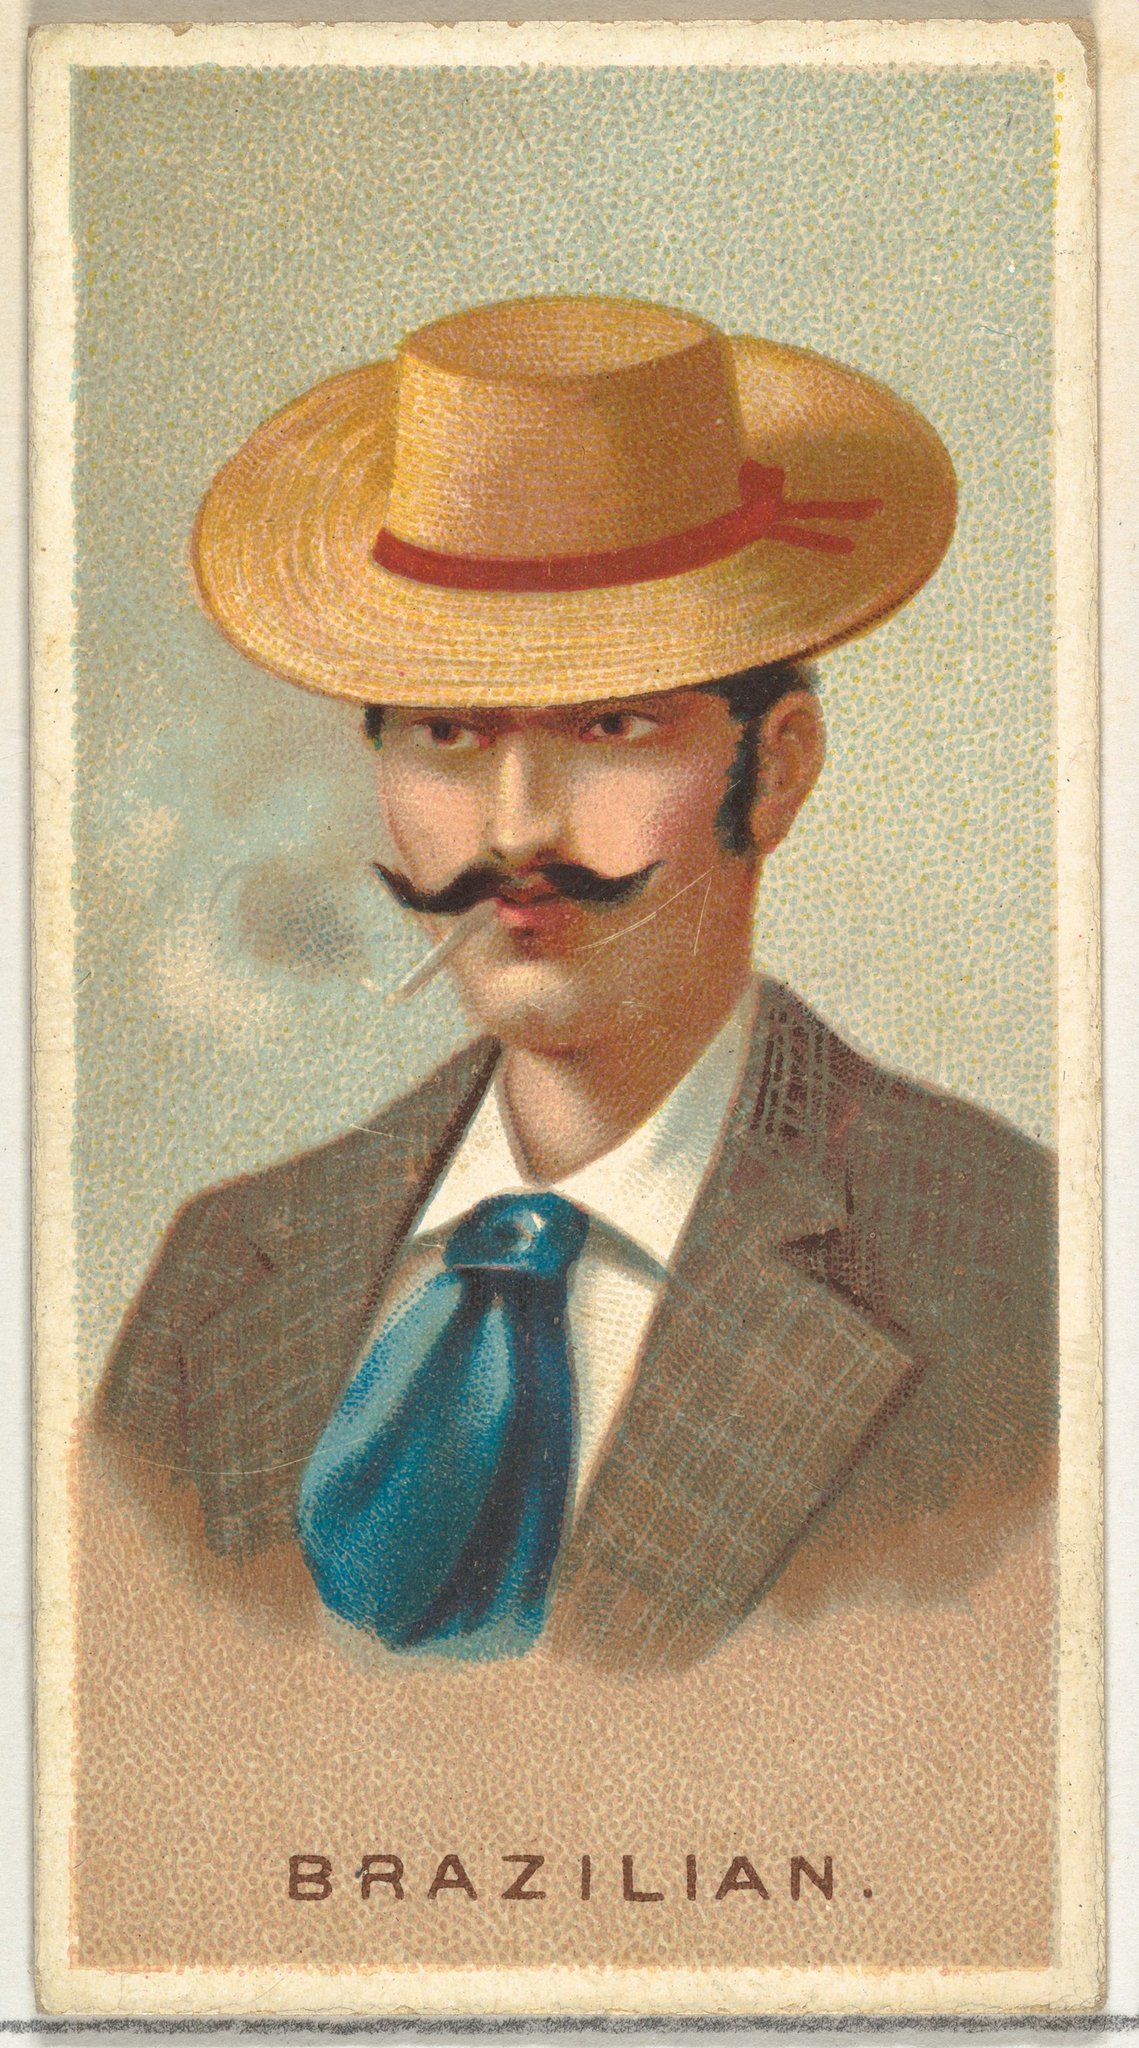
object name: print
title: Brazilian, from World's Smokers series (N33) for Allen & Ginter Cigarettes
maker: allen & ginter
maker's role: publisher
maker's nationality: american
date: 1888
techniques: color lithograph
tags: men,smoking